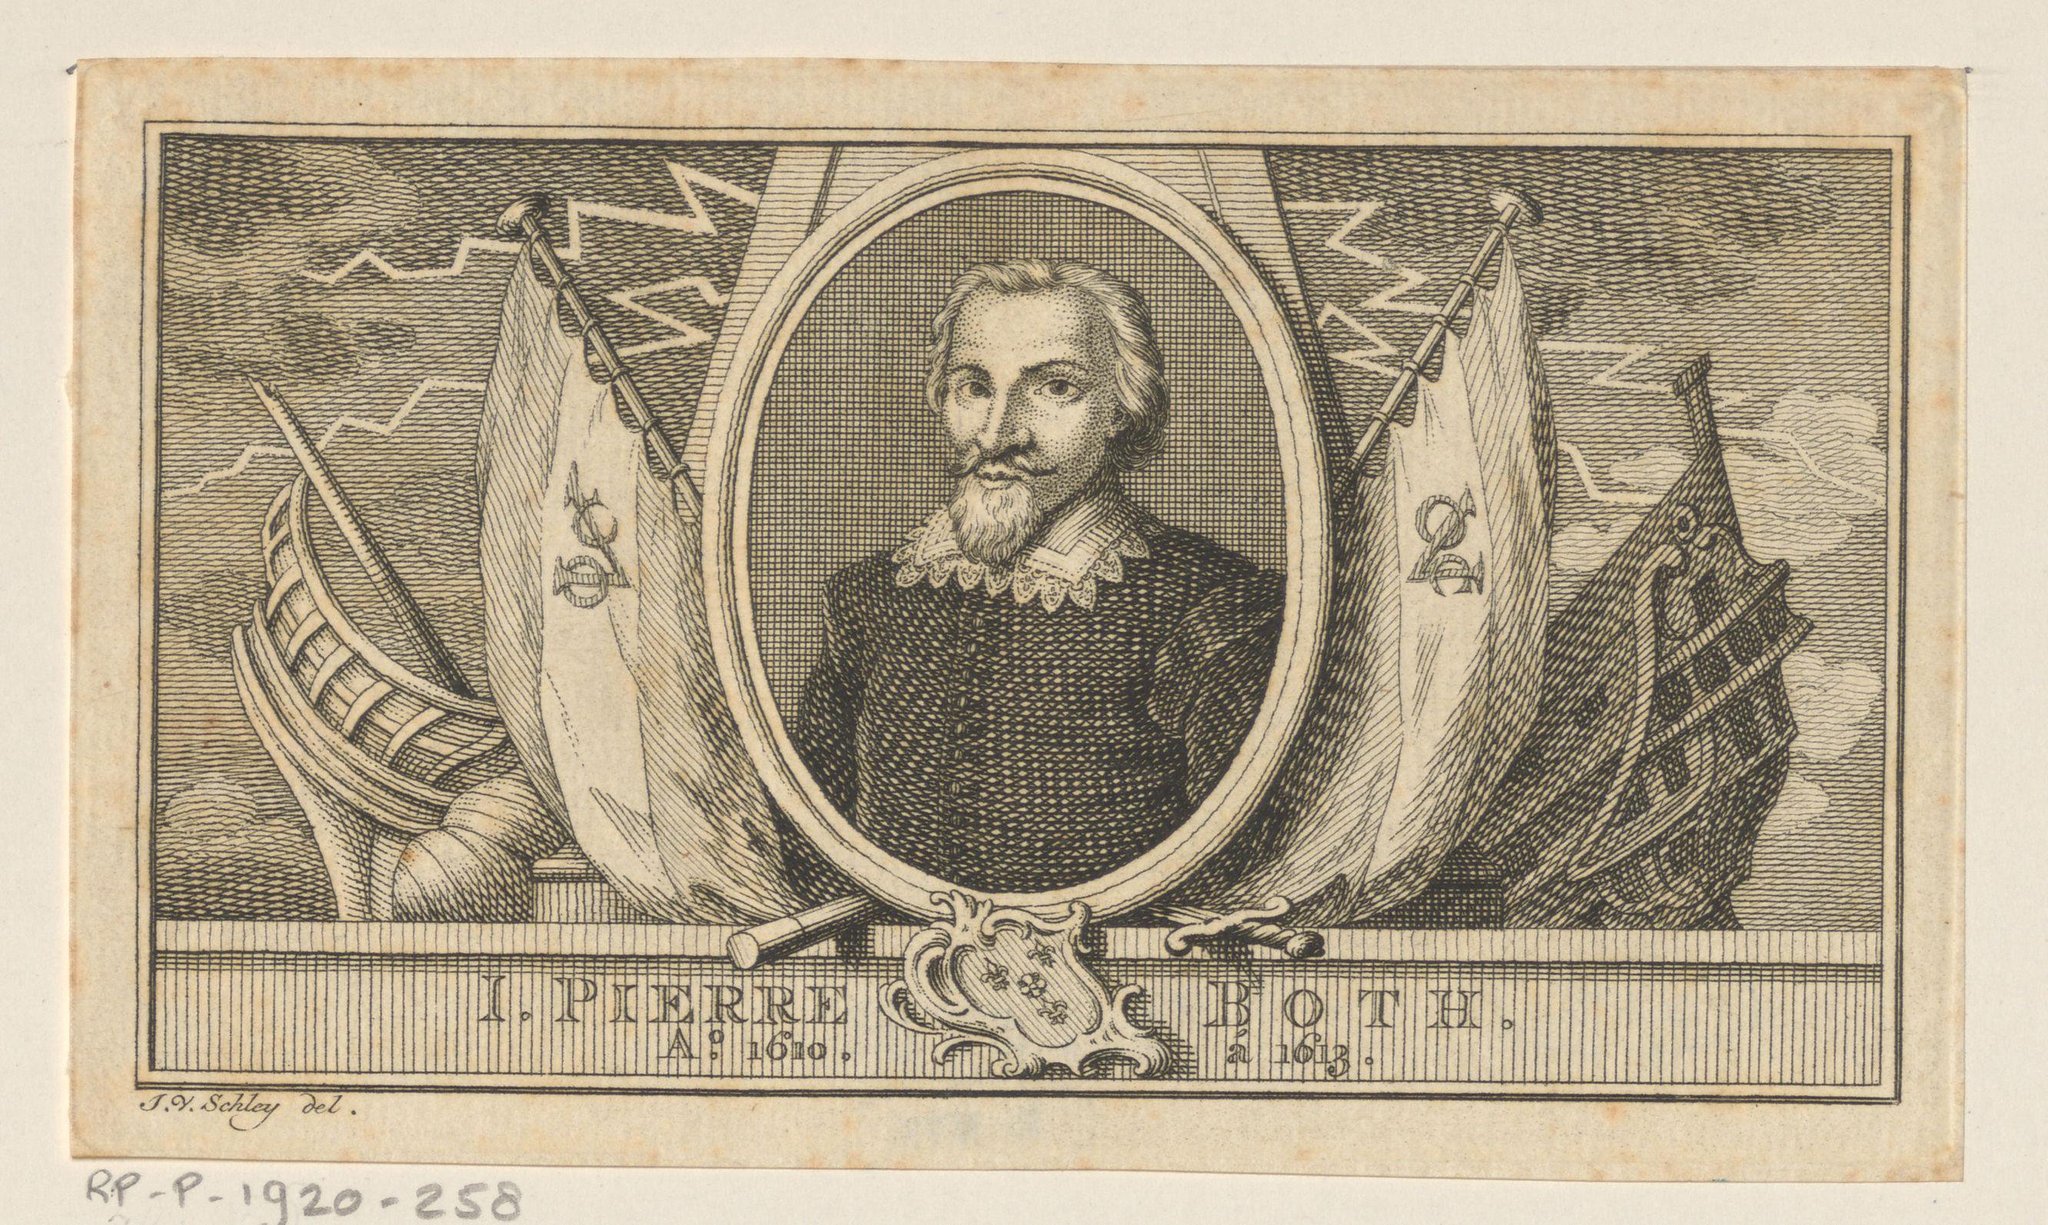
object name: print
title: Portret van Pieter Both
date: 1763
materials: paper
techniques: engraving, etching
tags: colonial governor, historical persons, armorial bearing, heraldry, flag, colours (as symbol of the state, etc.)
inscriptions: collector's mark: Lugt 2228, collector's mark: Lugt 964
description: Prent met tekst op verso gebruikt in: Du Bois, J.P.J. Vies des gouverneurs généraux, avec l'abrégé de l'histoire des établissemens hollandois aux Indes Orientales. Den Haag: Pieter de Hondt, 1763.